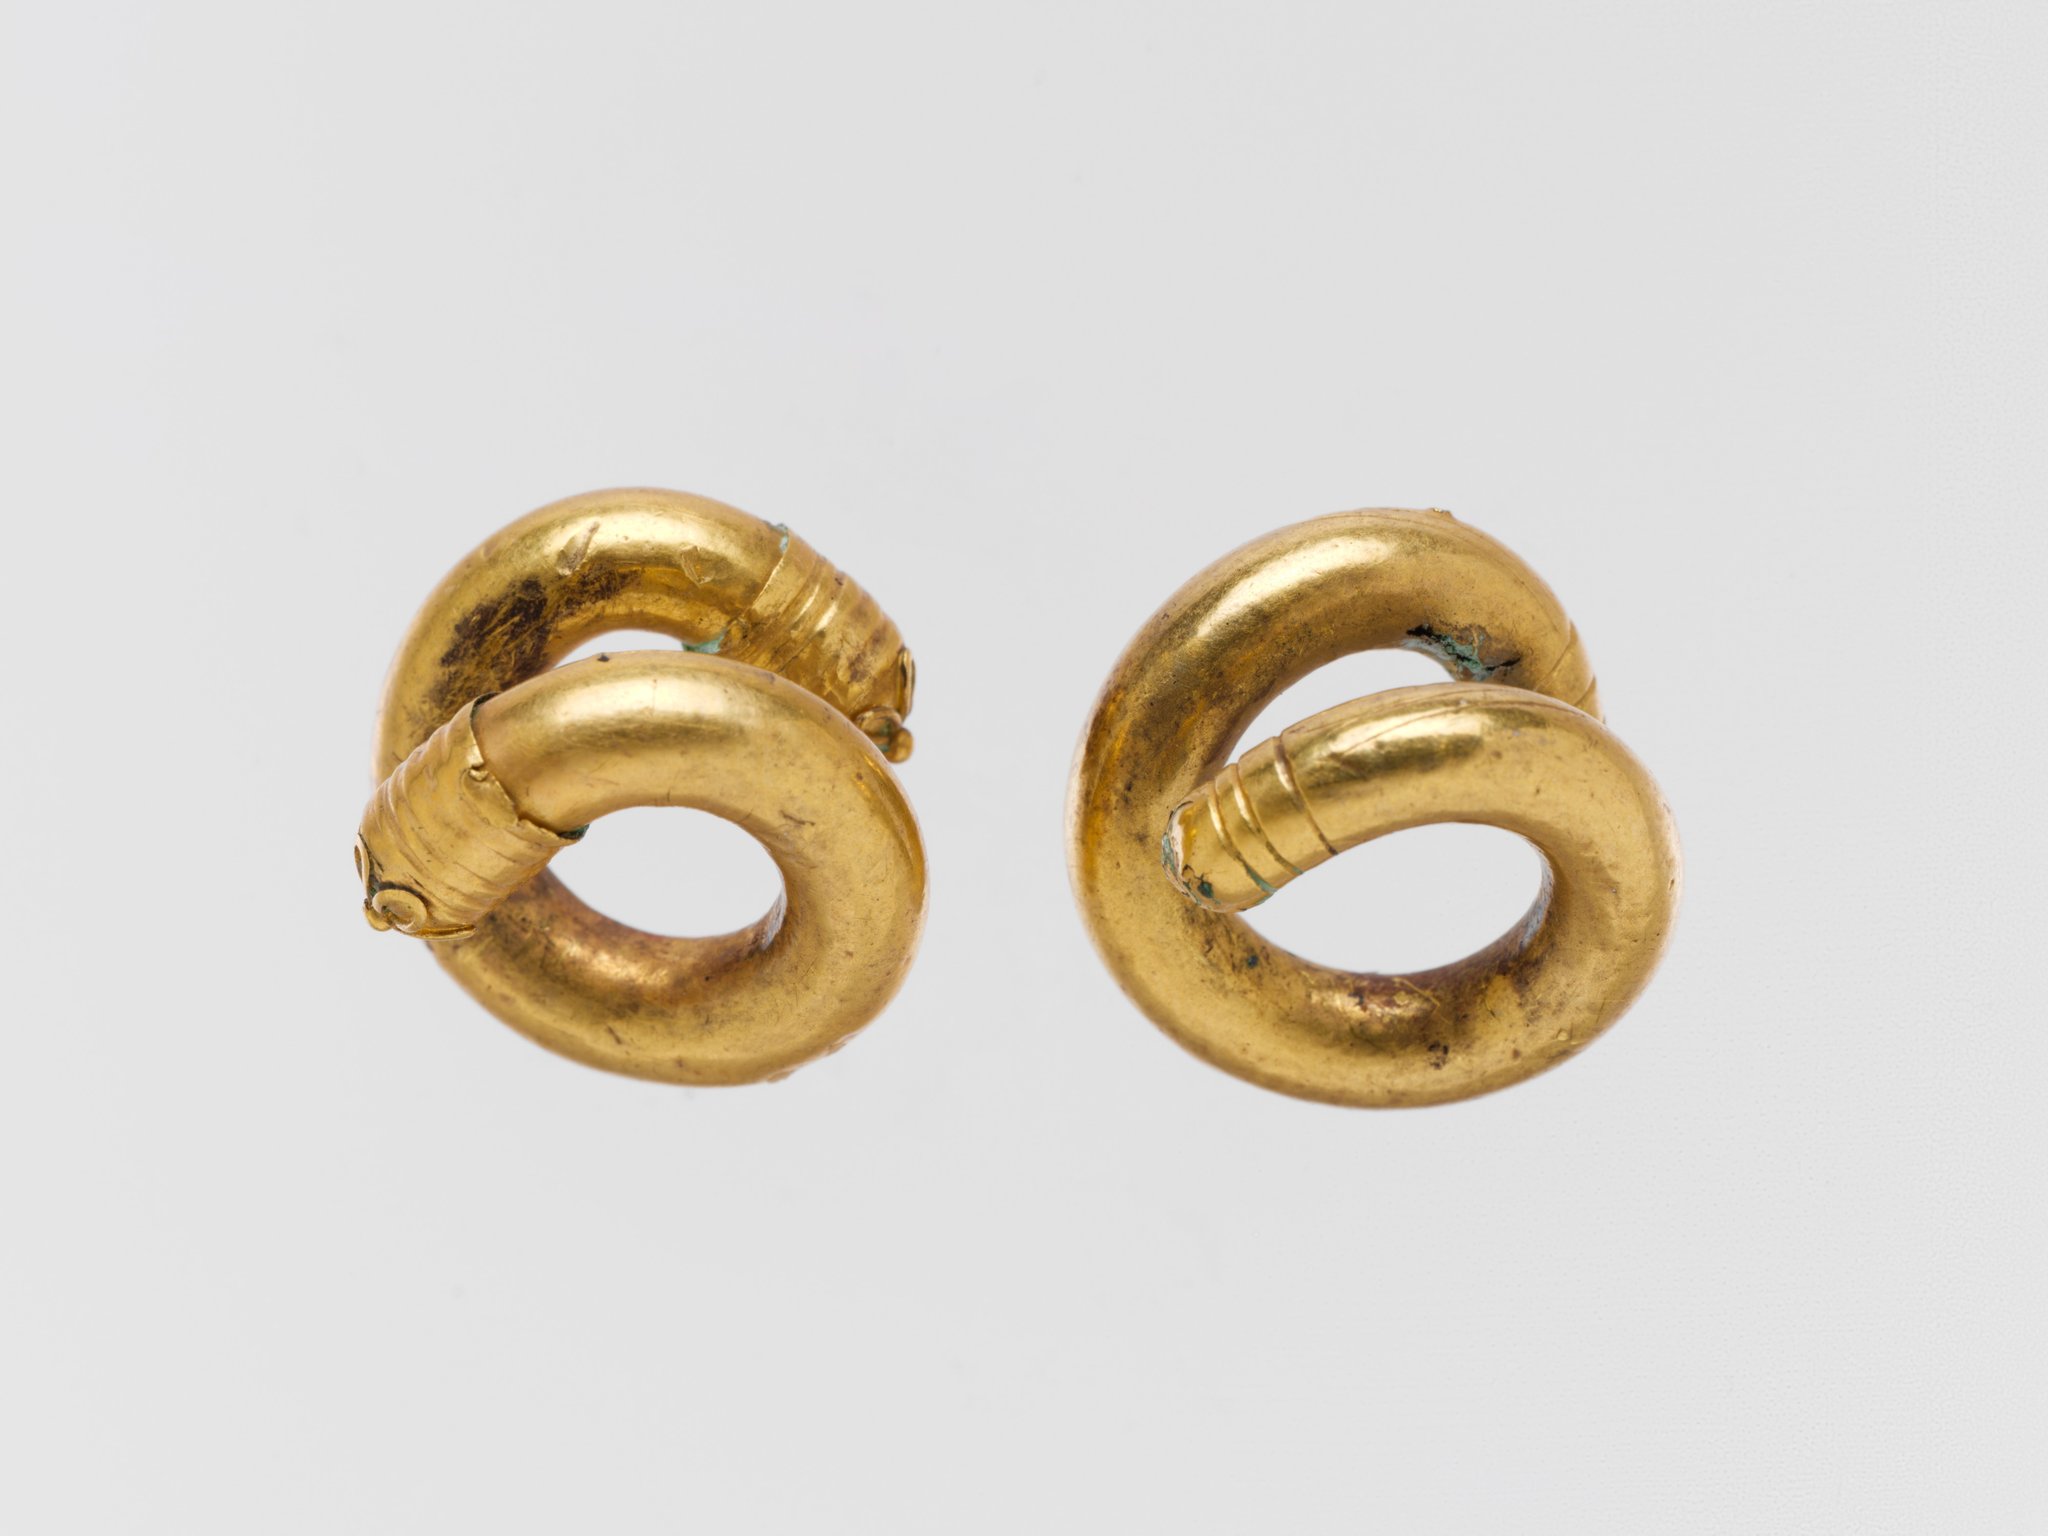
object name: earring, spiral with gold lion head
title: Gold and copper alloy spiral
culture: cypriot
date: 500-401 BCE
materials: bronze, gold